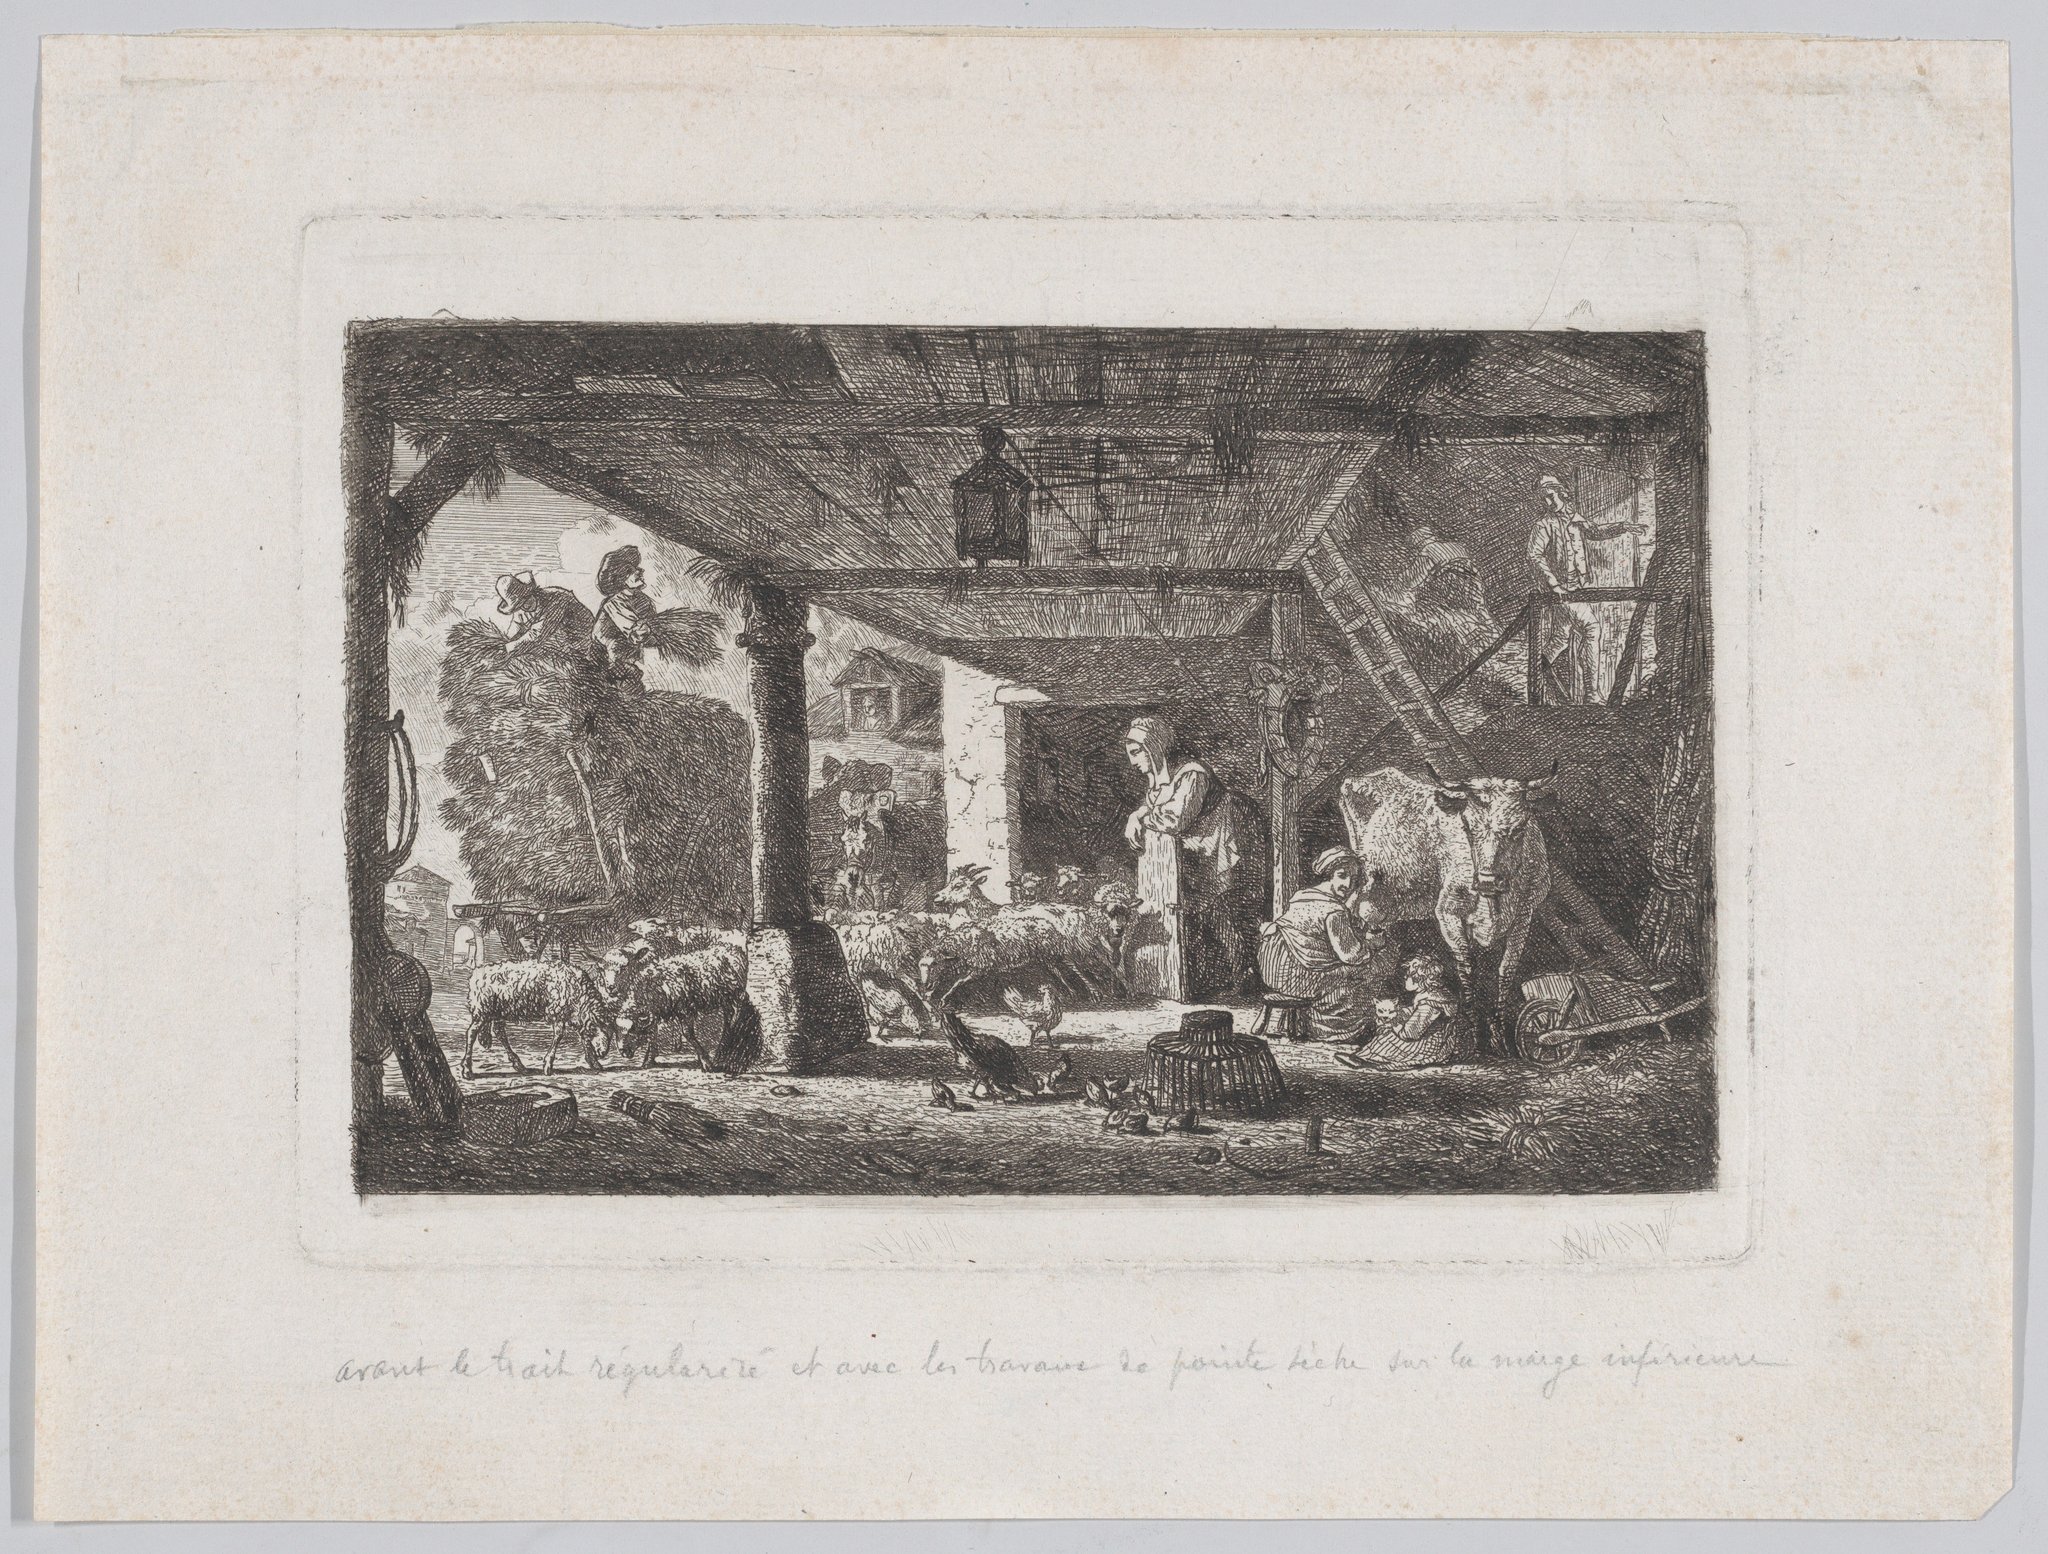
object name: print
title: Interior of a barn with an unloading haywagon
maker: jean louis de marne (called demarnette)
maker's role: artist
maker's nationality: french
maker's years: 1754-1829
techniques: drypoint, etching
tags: barns,women,cows,sheep